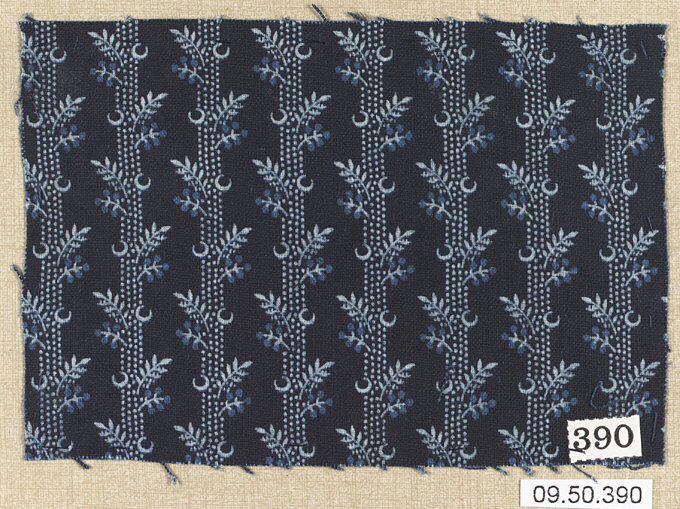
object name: piece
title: Piece (one of 116)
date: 1801-1900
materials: cotton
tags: leaves